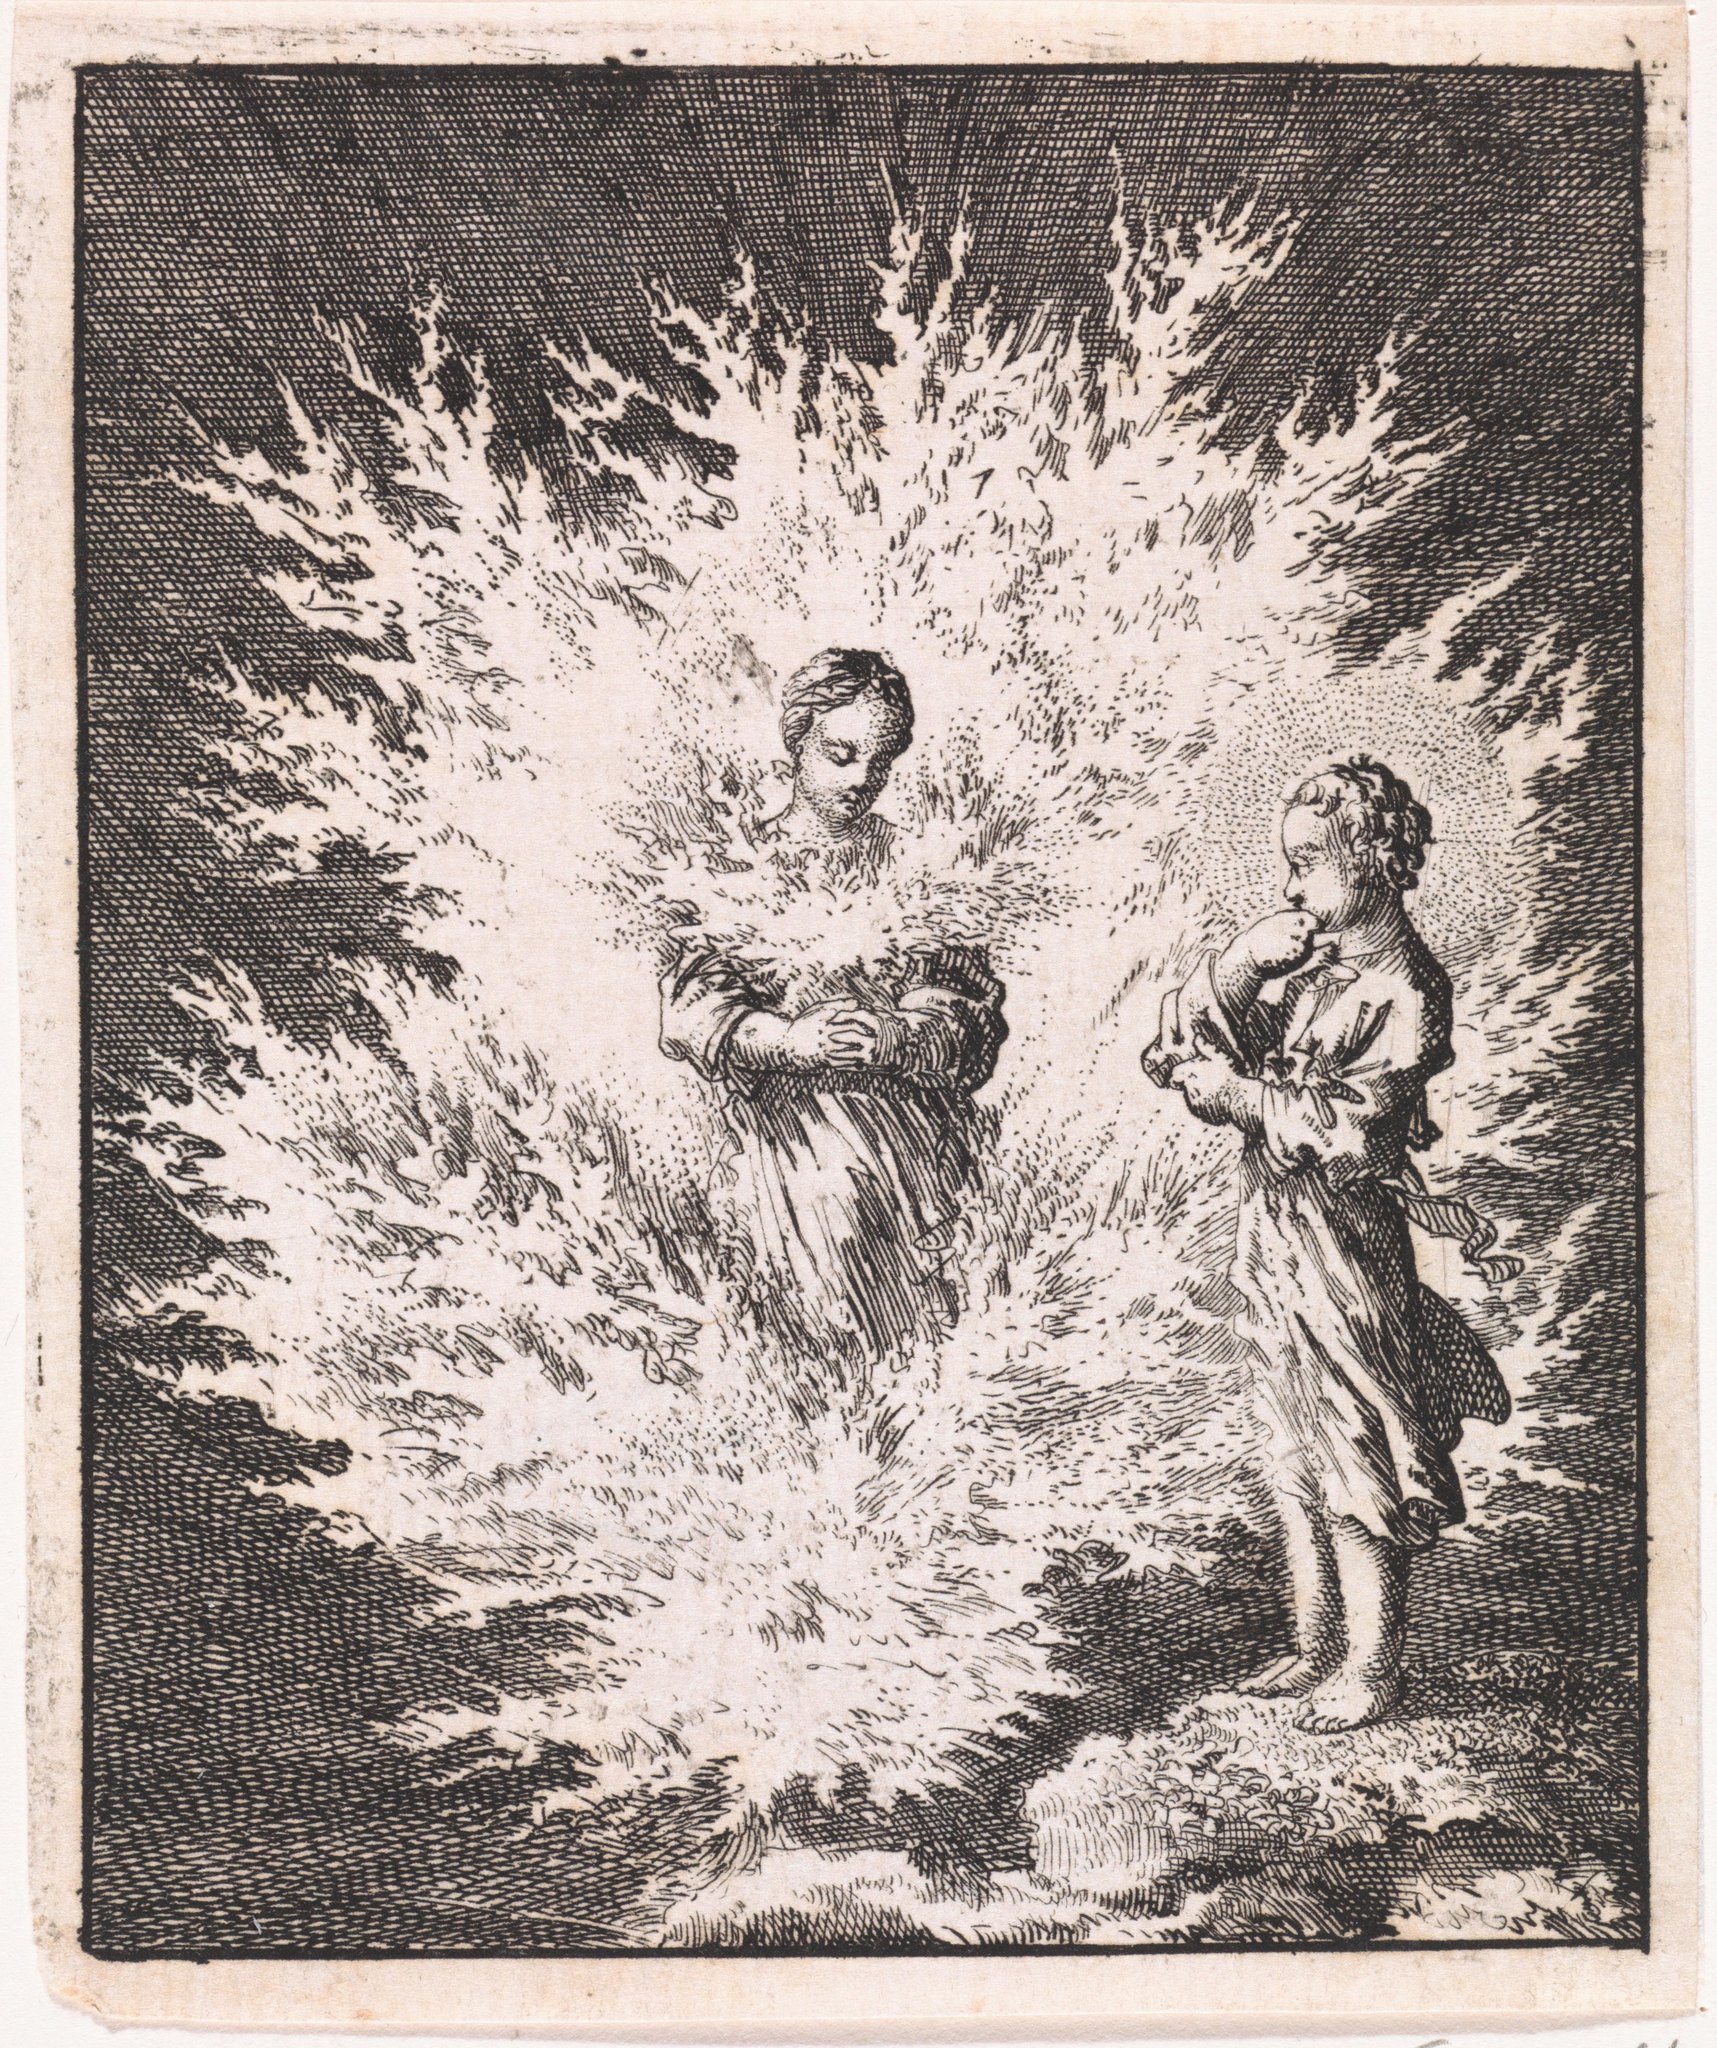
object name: print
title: Jezus met de Ziel, die geheel door vlammen is omringd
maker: jan luyken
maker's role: draughtsman, print maker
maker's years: 1649-1712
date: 1714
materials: paper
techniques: etching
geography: amsterdam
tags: holy ghost represented as flames (+ variant), christ and the soul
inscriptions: collector's mark: Lugt 2228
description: Proefdruk van illustratie uit: Luyken, Jan. Jezus en de Ziel, 3 delen. Amsterdam: Wed. Pieter Arentsz II en Cornelis van der Sys, 1714, dl. II, p. 113.